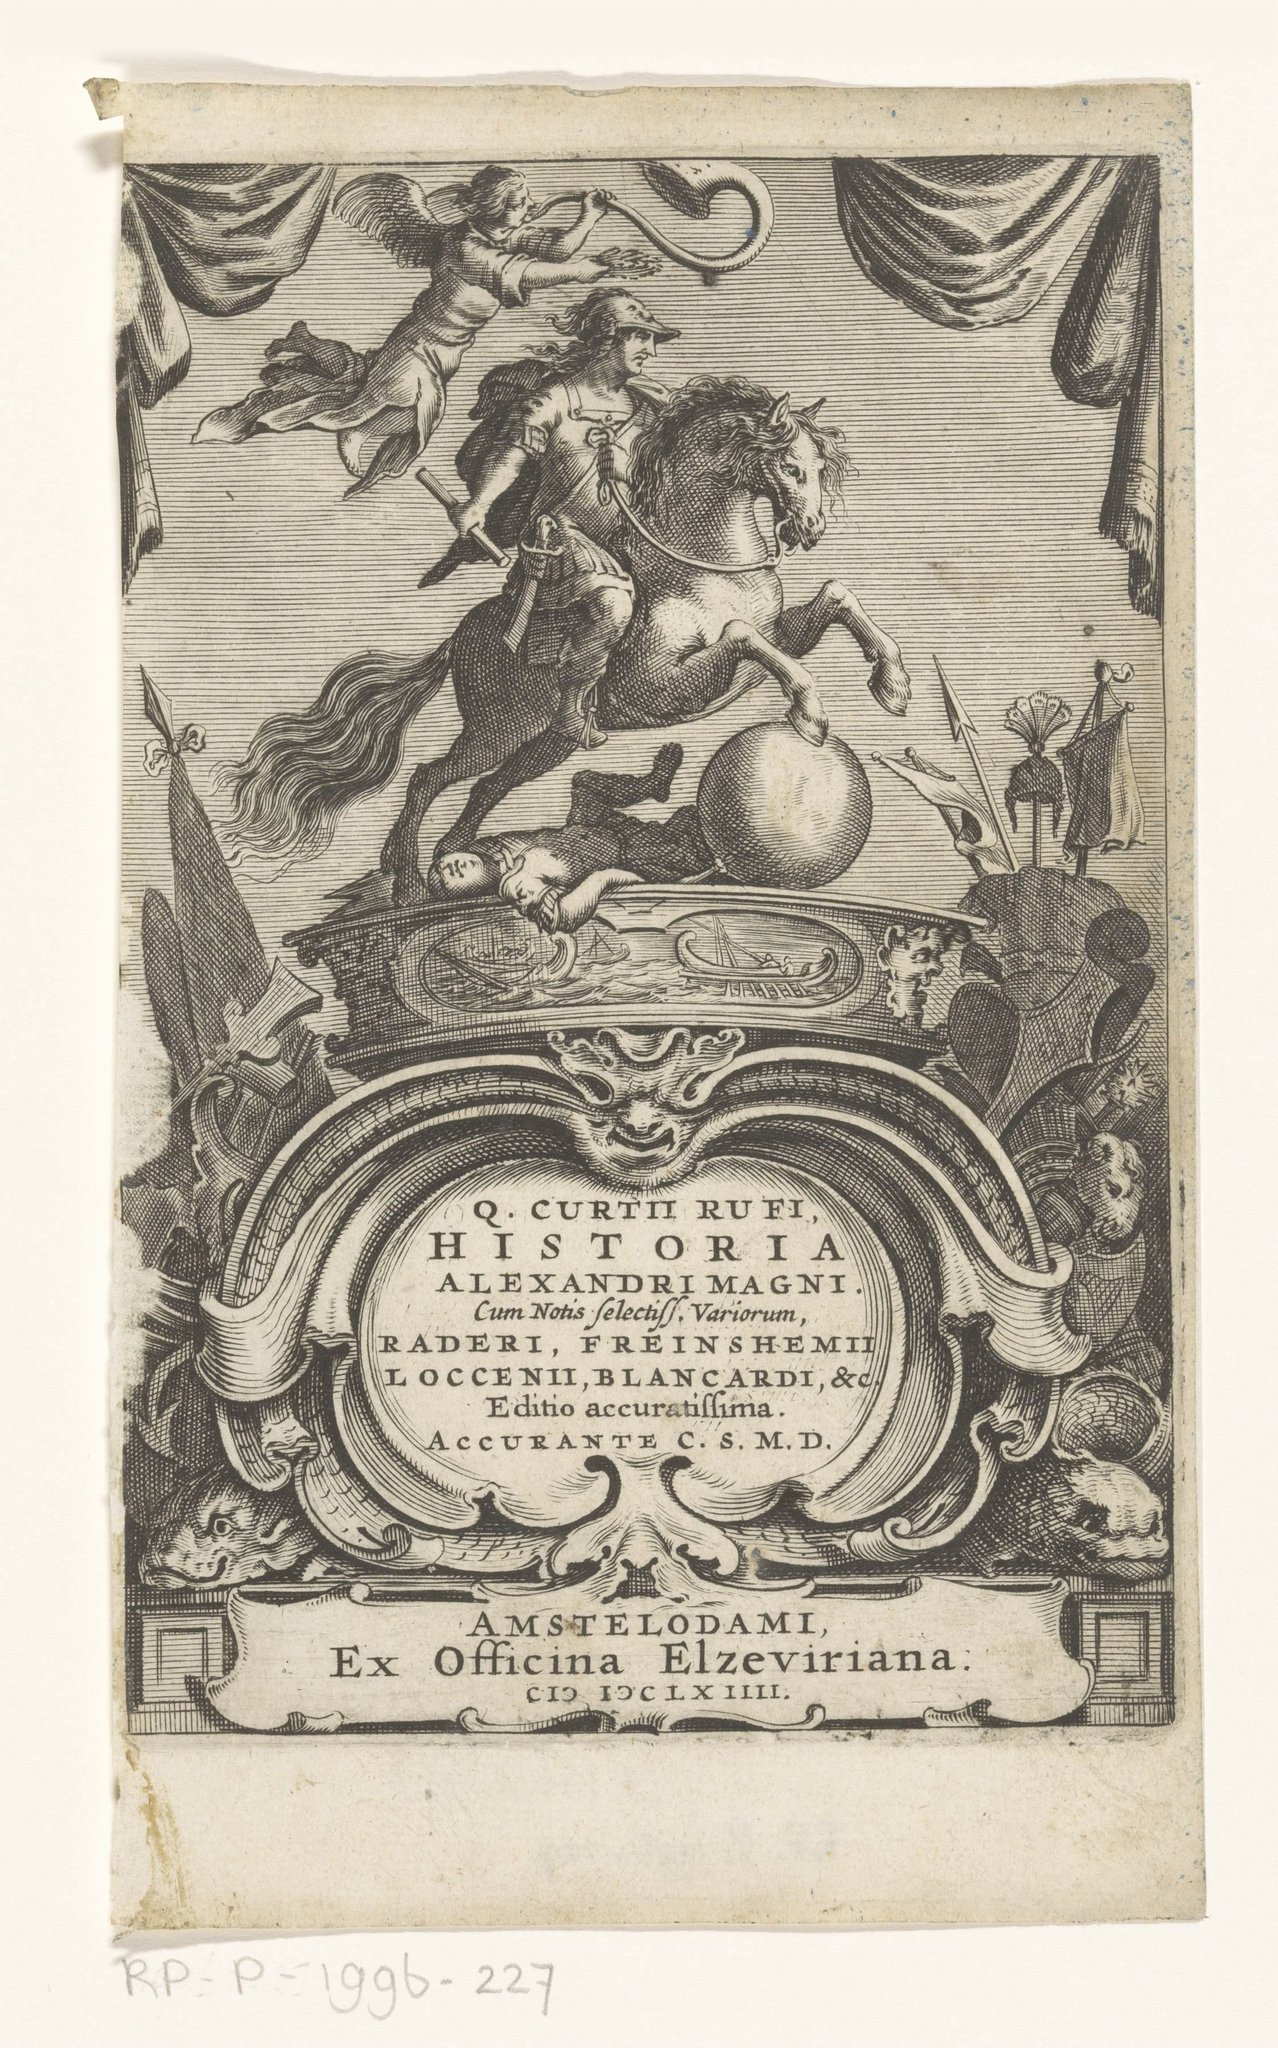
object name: titelblad, titelpagina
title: Titelpagina voor: Quintus Curtius Rufus, Historia Alexandri Magni, 1664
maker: Anonymous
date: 1664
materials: paper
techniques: engraving, etching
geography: leiden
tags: (story of) alexander the great, fama as roman personification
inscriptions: collector's mark: Lugt 2228, collector's mark: Lugt 2760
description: Een cartouche met de titel waarboven Alexander de Grote te paard. Onder het paard ligt een gevallen figuur en een wereldbol. Aan de bovenzijde blaast Fama op een bazuin.